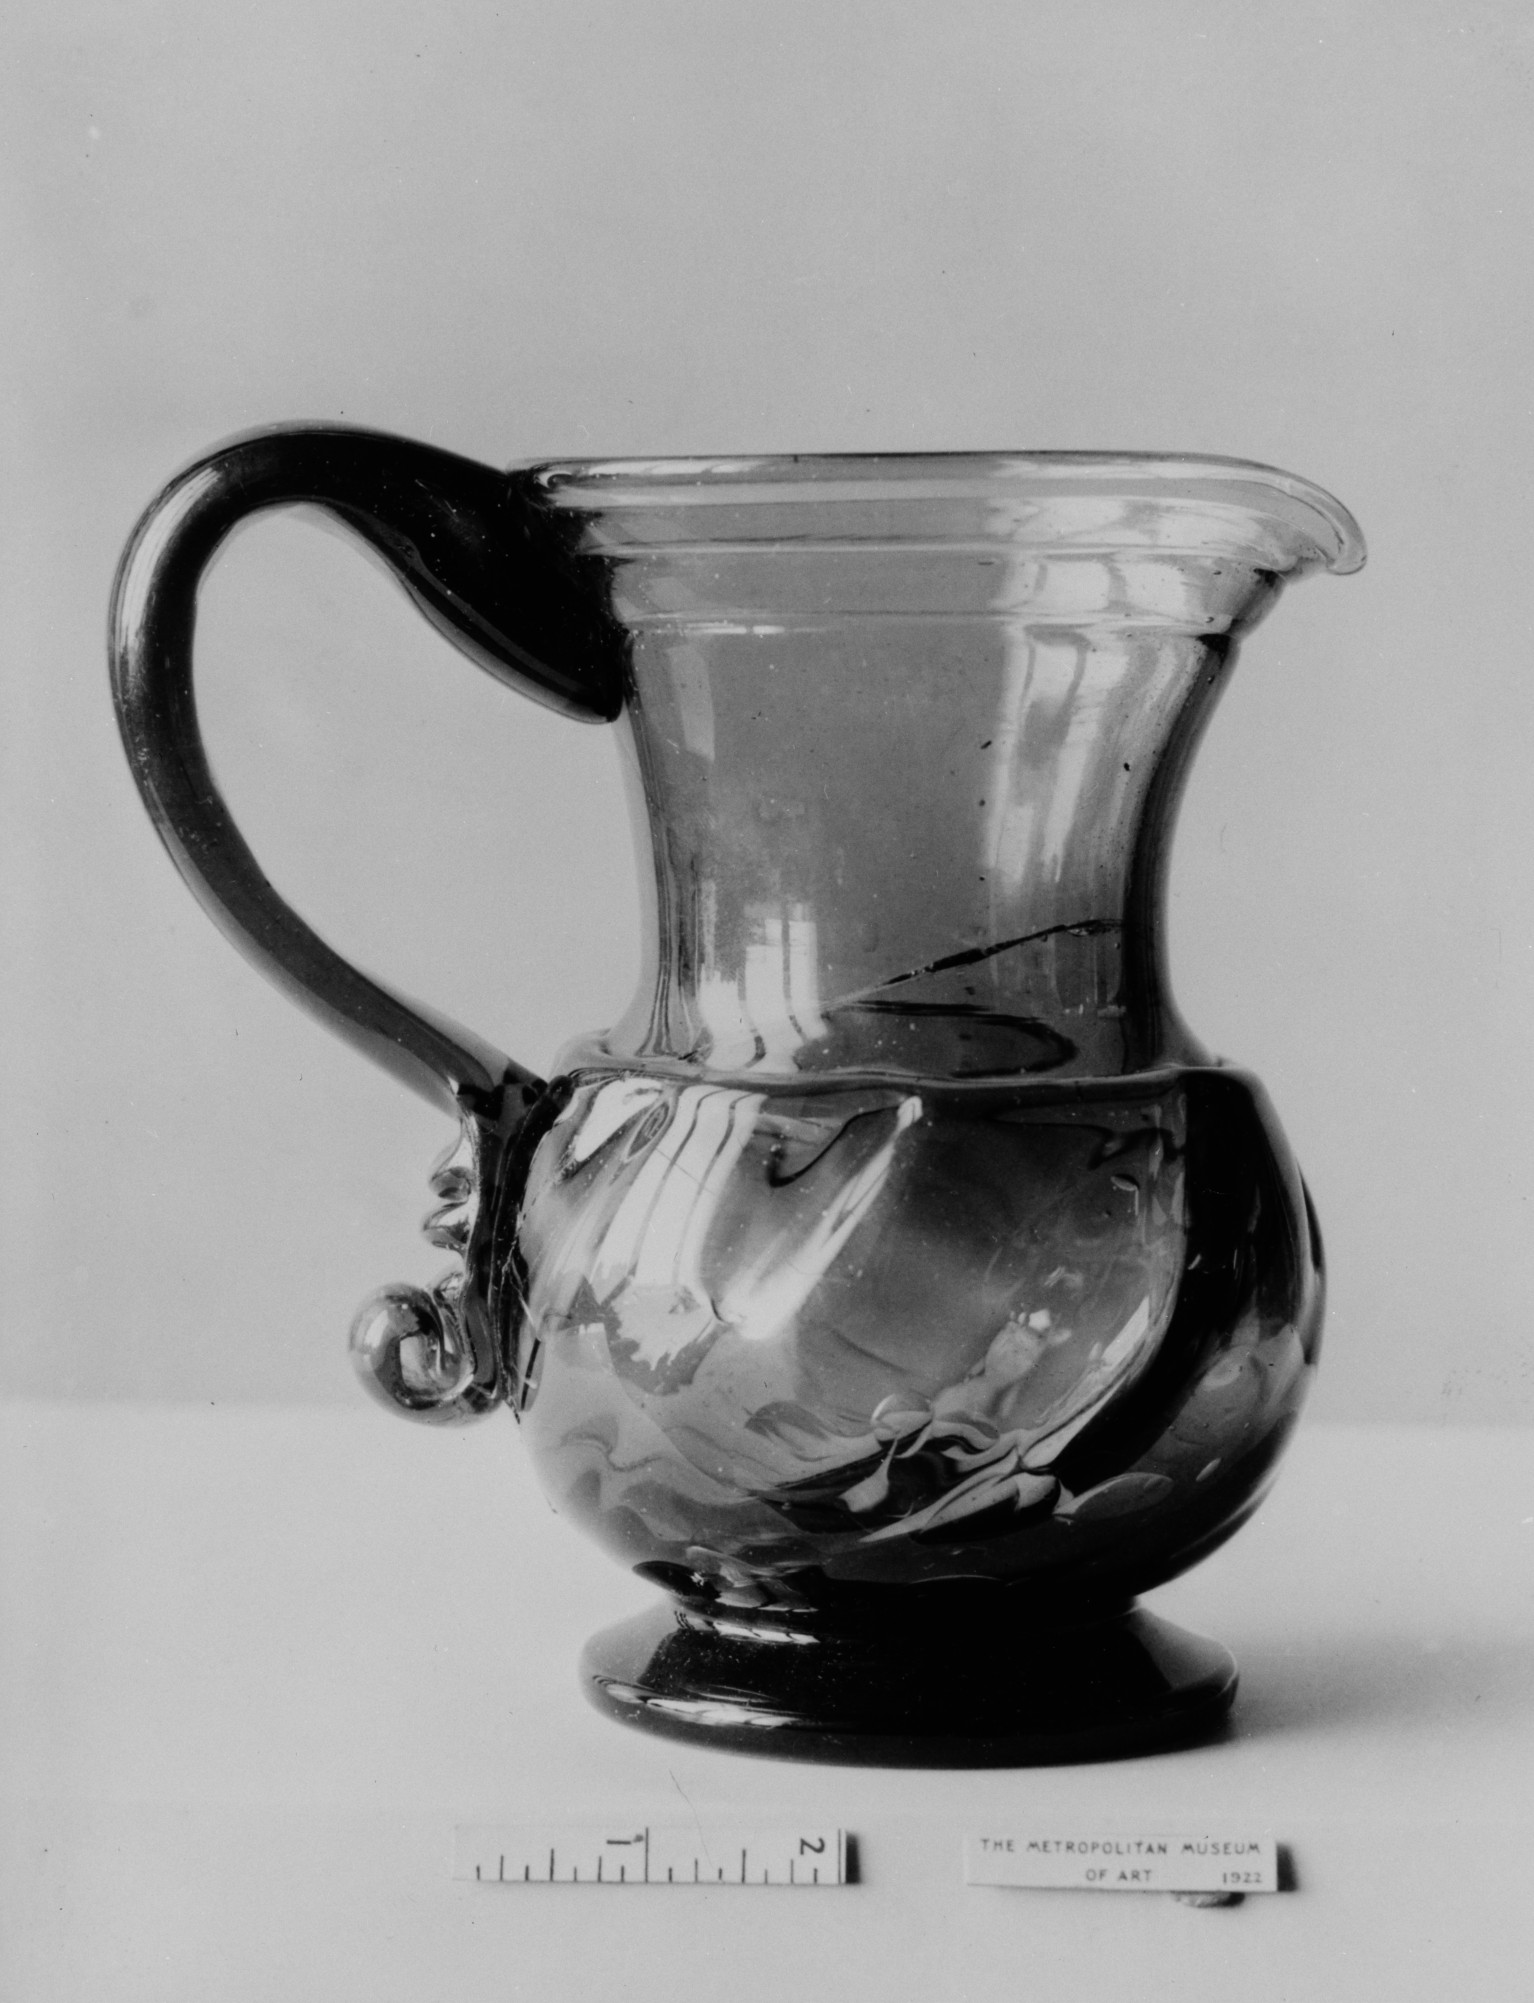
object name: pitcher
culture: american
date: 1700-1800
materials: glass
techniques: glassblowing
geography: united states